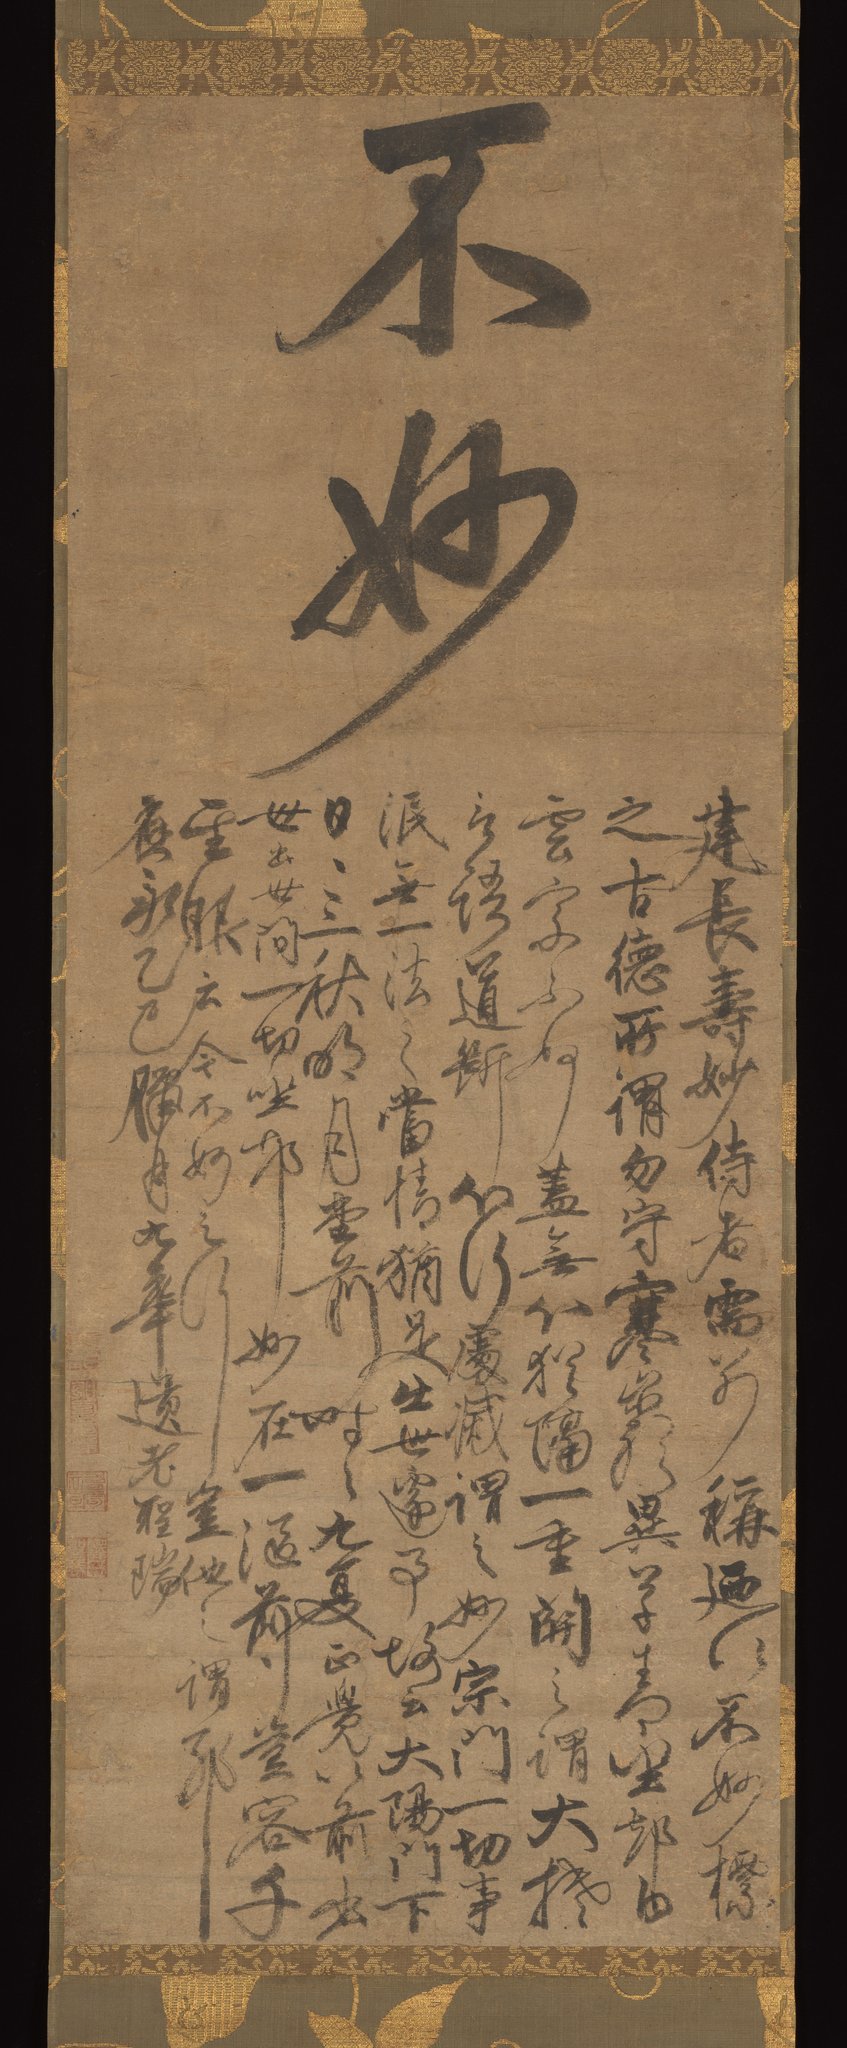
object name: hanging scroll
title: Bestowing the Buddhist Name “Fumyō”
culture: japanese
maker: ichidon shōzui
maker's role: artist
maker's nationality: japanese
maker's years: 1394-1428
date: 1425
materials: ink, paper